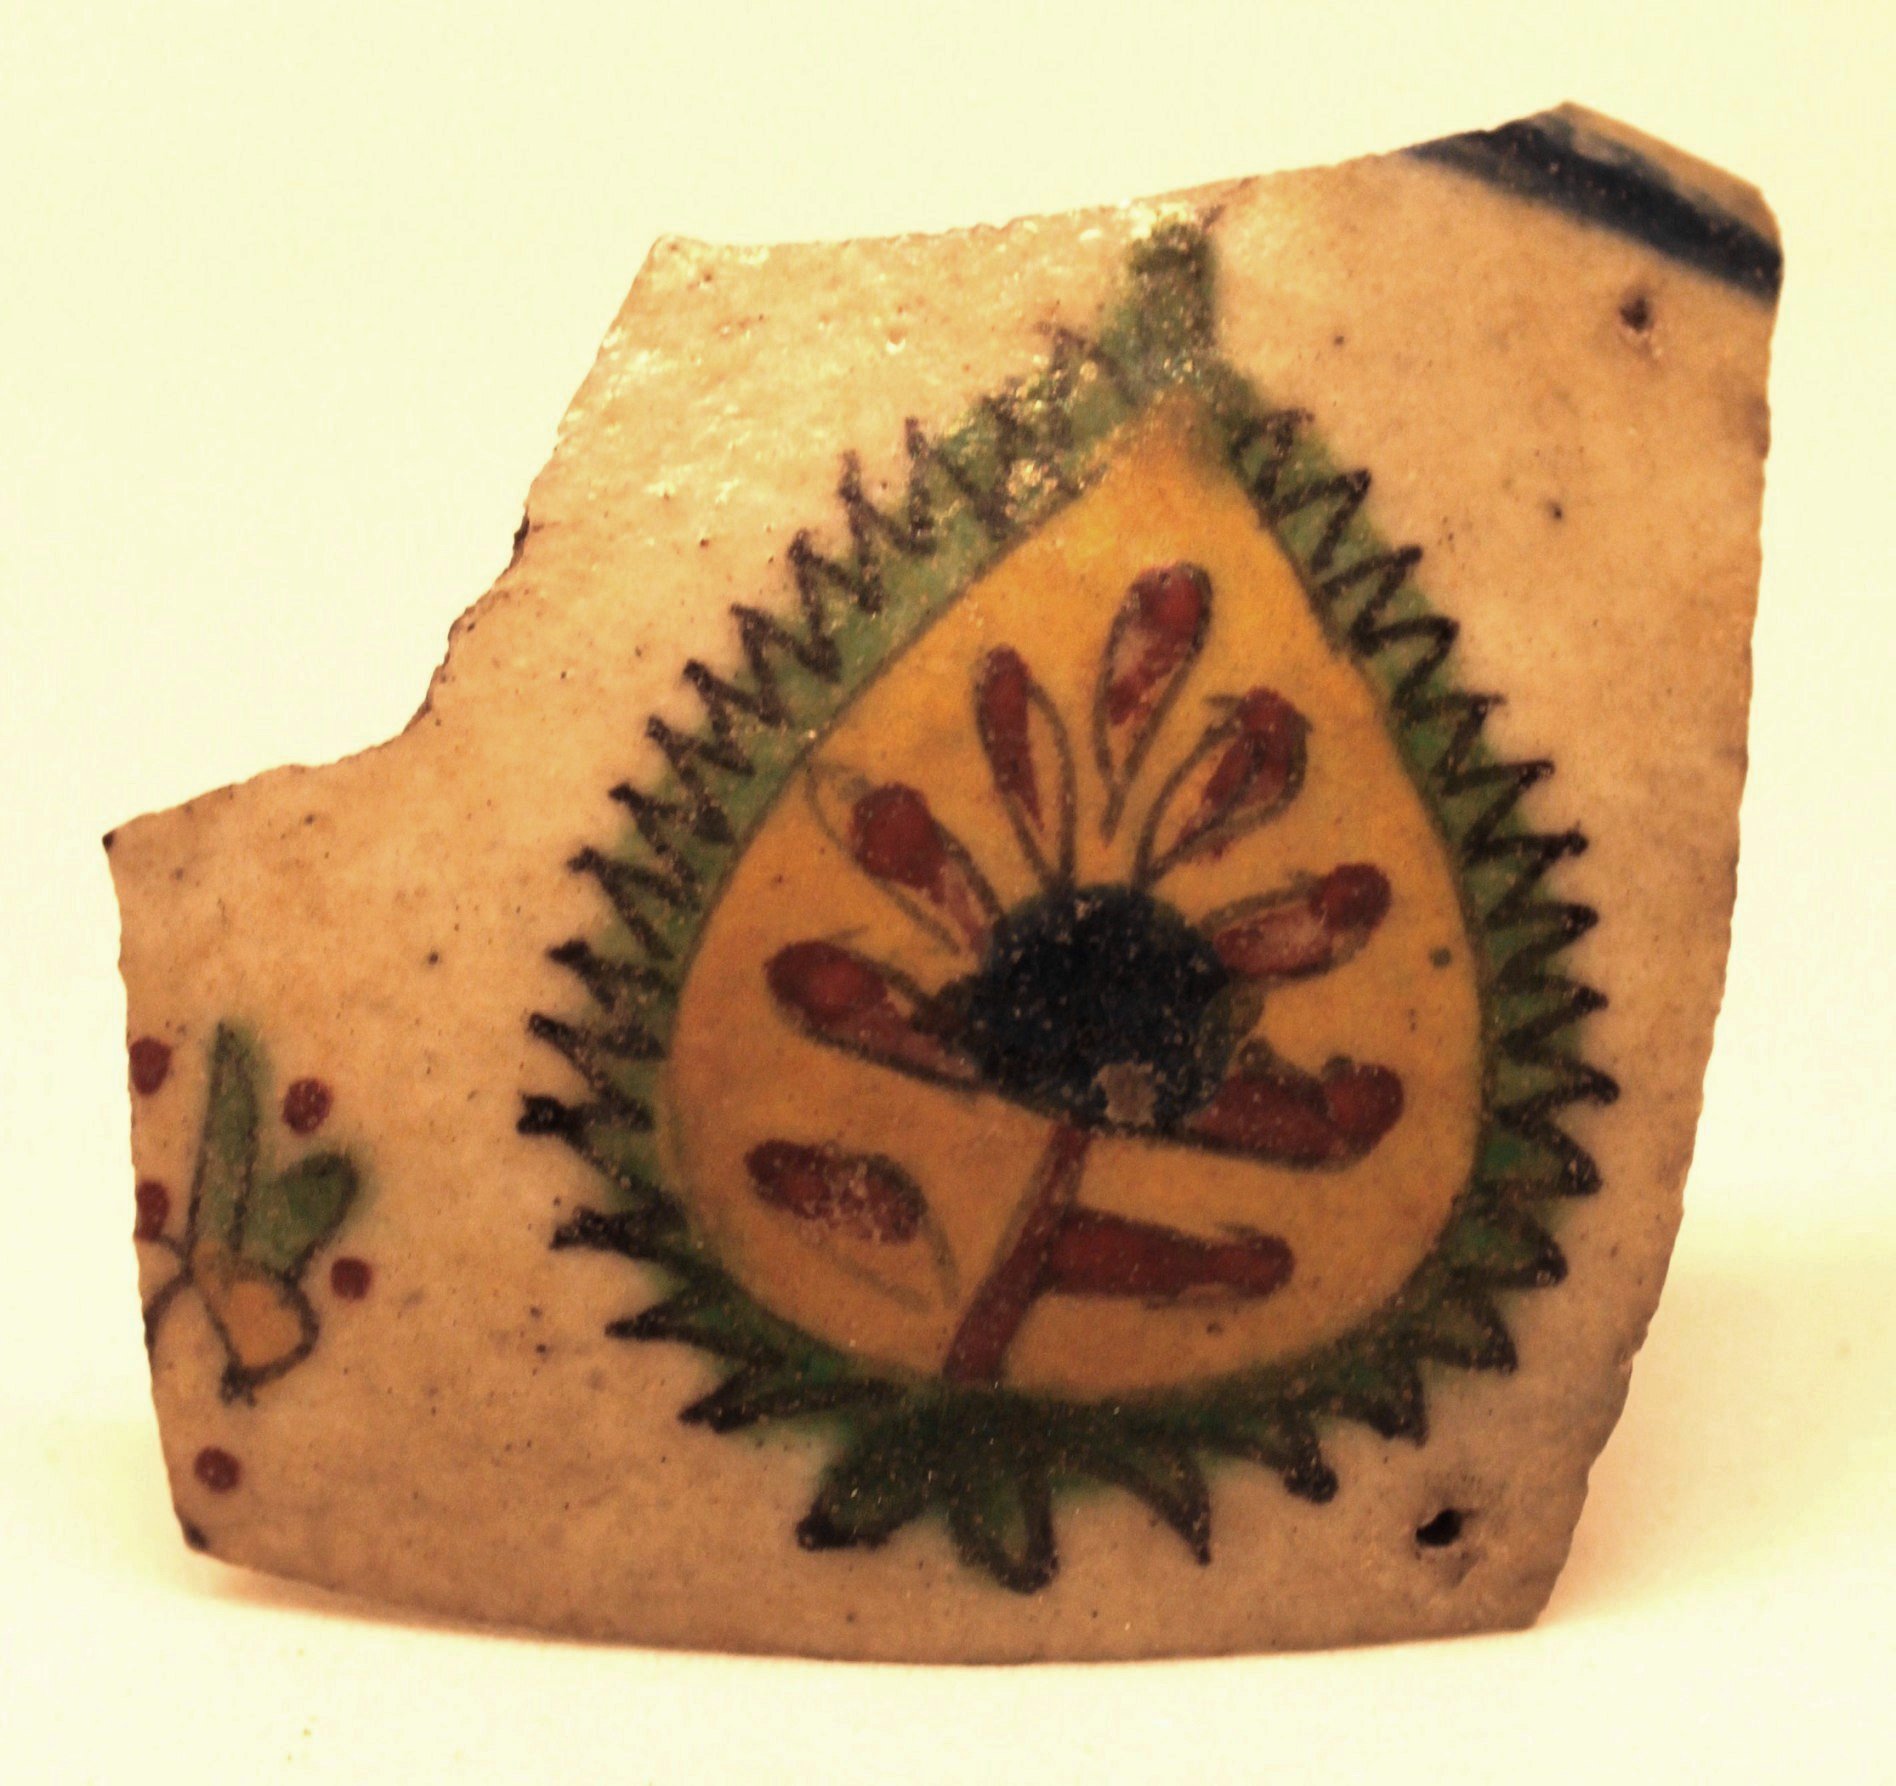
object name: fragment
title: Ceramic Fragment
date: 1701-1800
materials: glaze, stonepaste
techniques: painting, polychrome, underglaze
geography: turkey